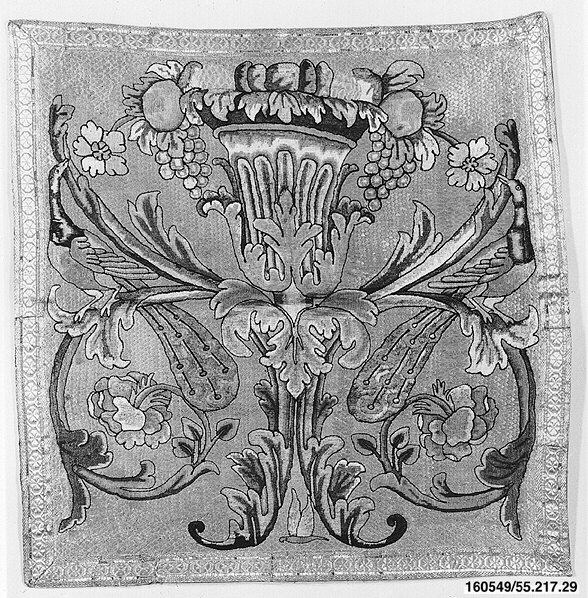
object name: panel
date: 1601-1800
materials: silk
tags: flowers,leaves